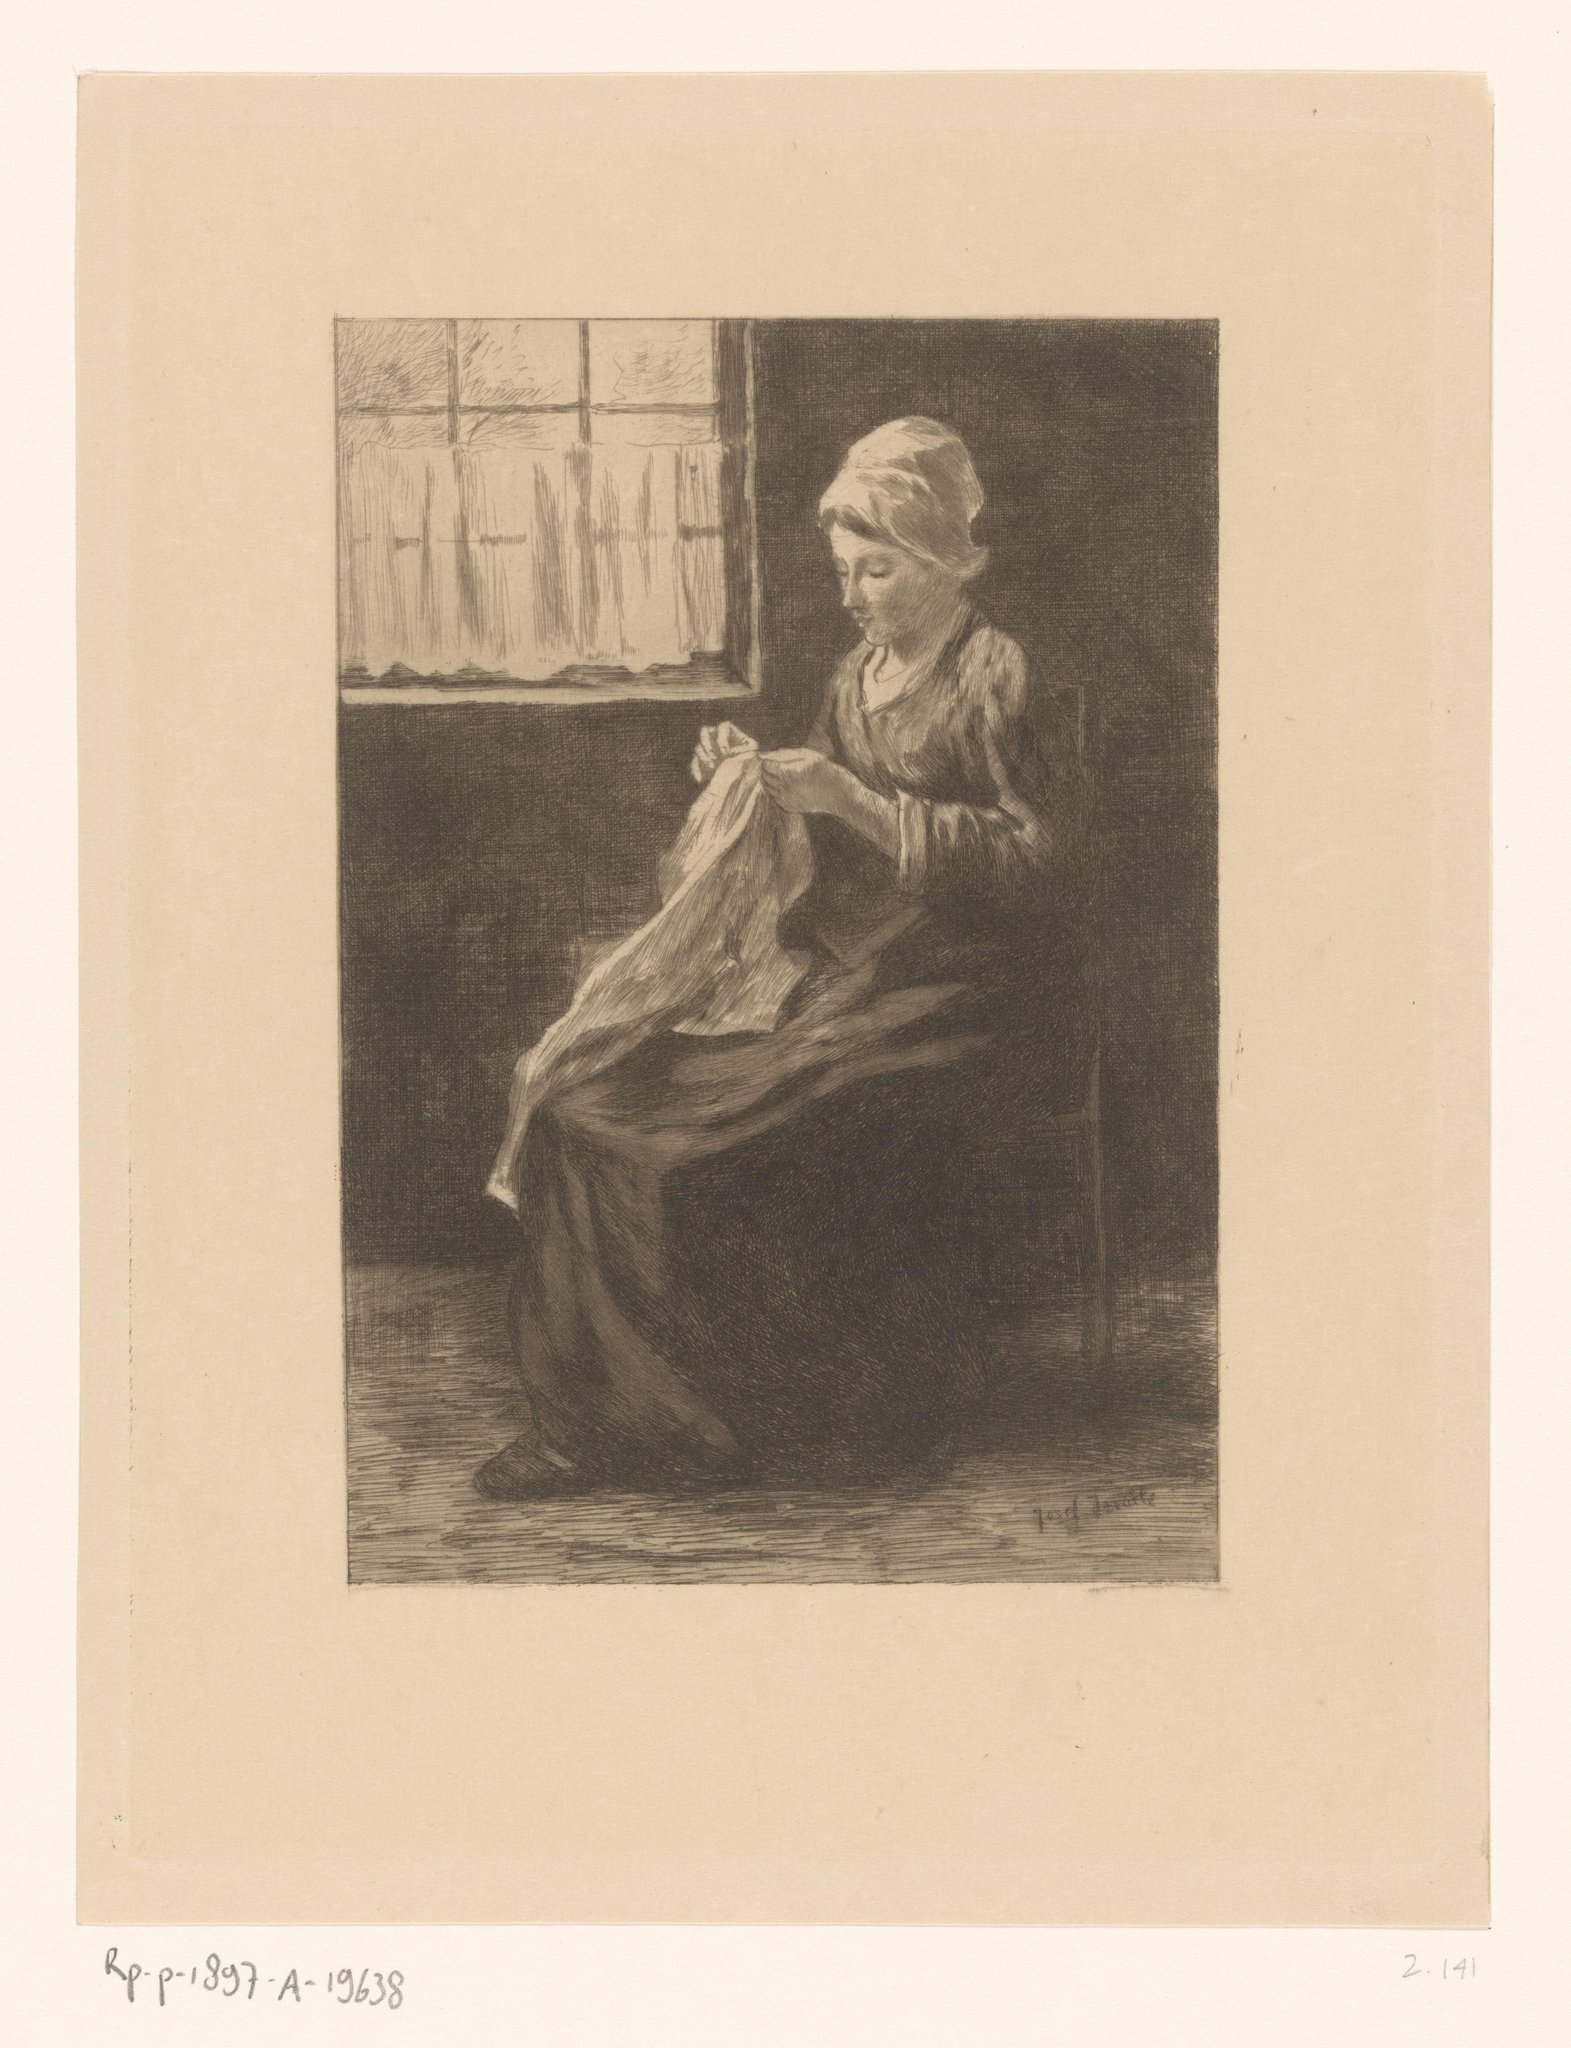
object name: print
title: Het naaistertje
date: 1867-1890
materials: paper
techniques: drypoint, etching, intaglio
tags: adult woman, sewing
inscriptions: collector's mark: Lugt 2228